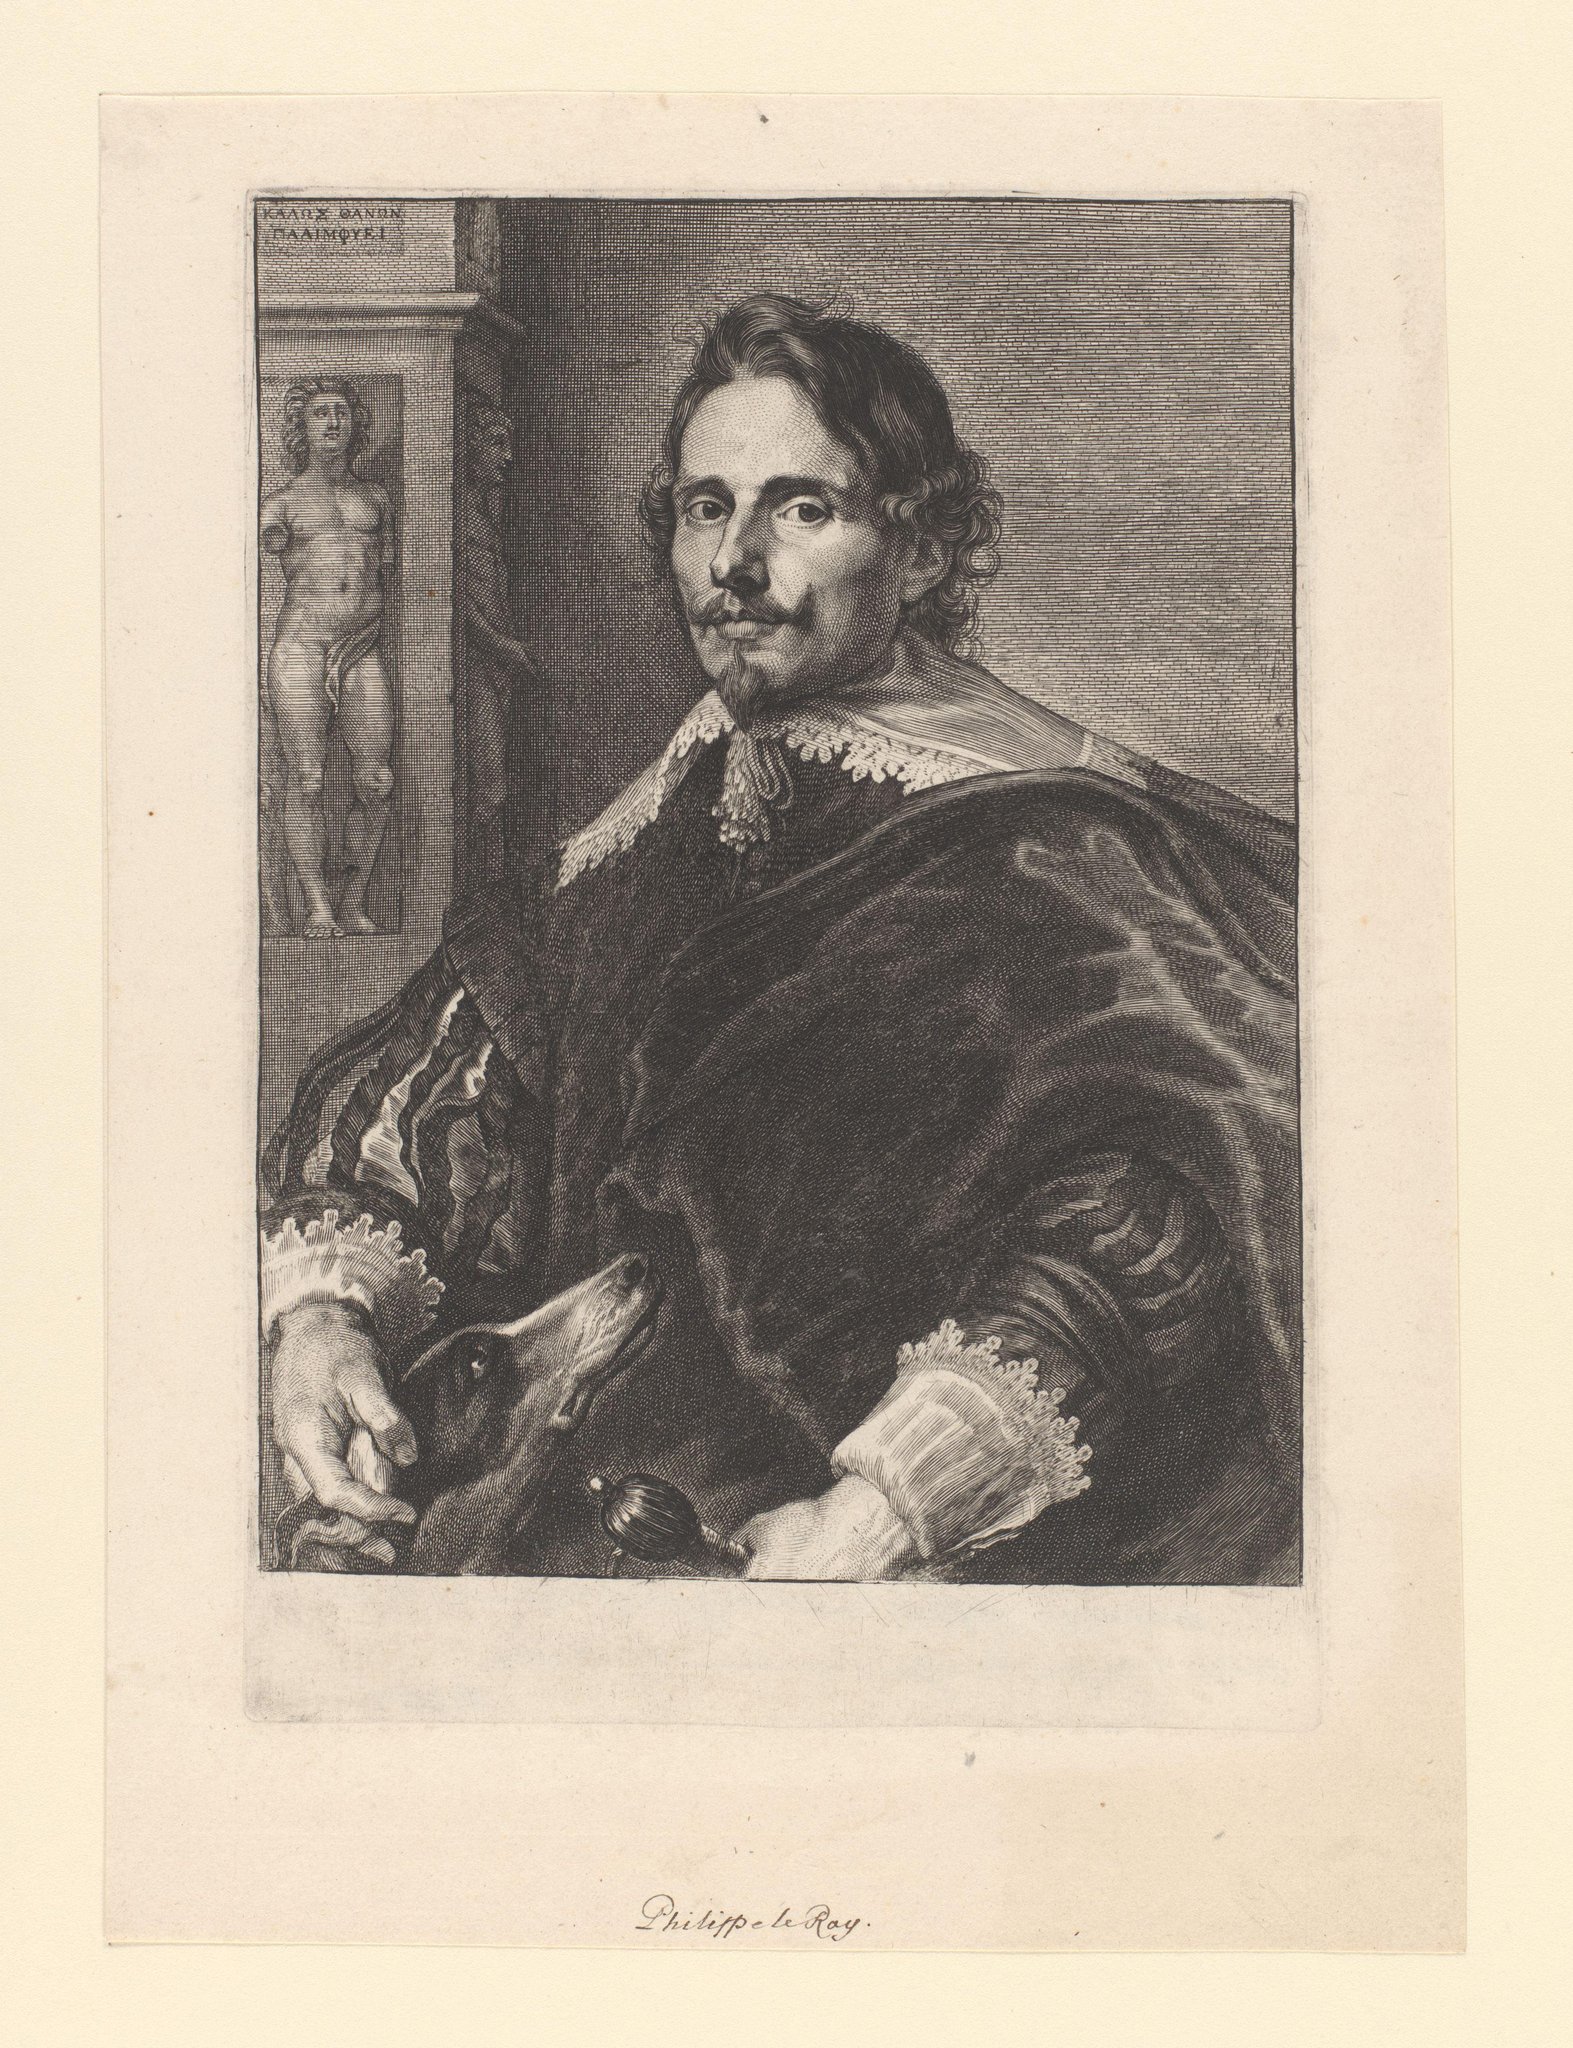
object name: print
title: Portret van Philippe Le Roy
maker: lucas vorsterman (i)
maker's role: print maker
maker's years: 1595-1675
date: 1630-1675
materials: paper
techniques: engraving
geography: antwerp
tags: dog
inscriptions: name: ‘Philippe le Roy’, collector's mark: Lugt 240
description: Portret van de kunstverzamelaar en diplomaat Philippe Le Roy, Heer van Ravels, Baron van Broechem, raadsheer van koning Filips IV van Spanje.